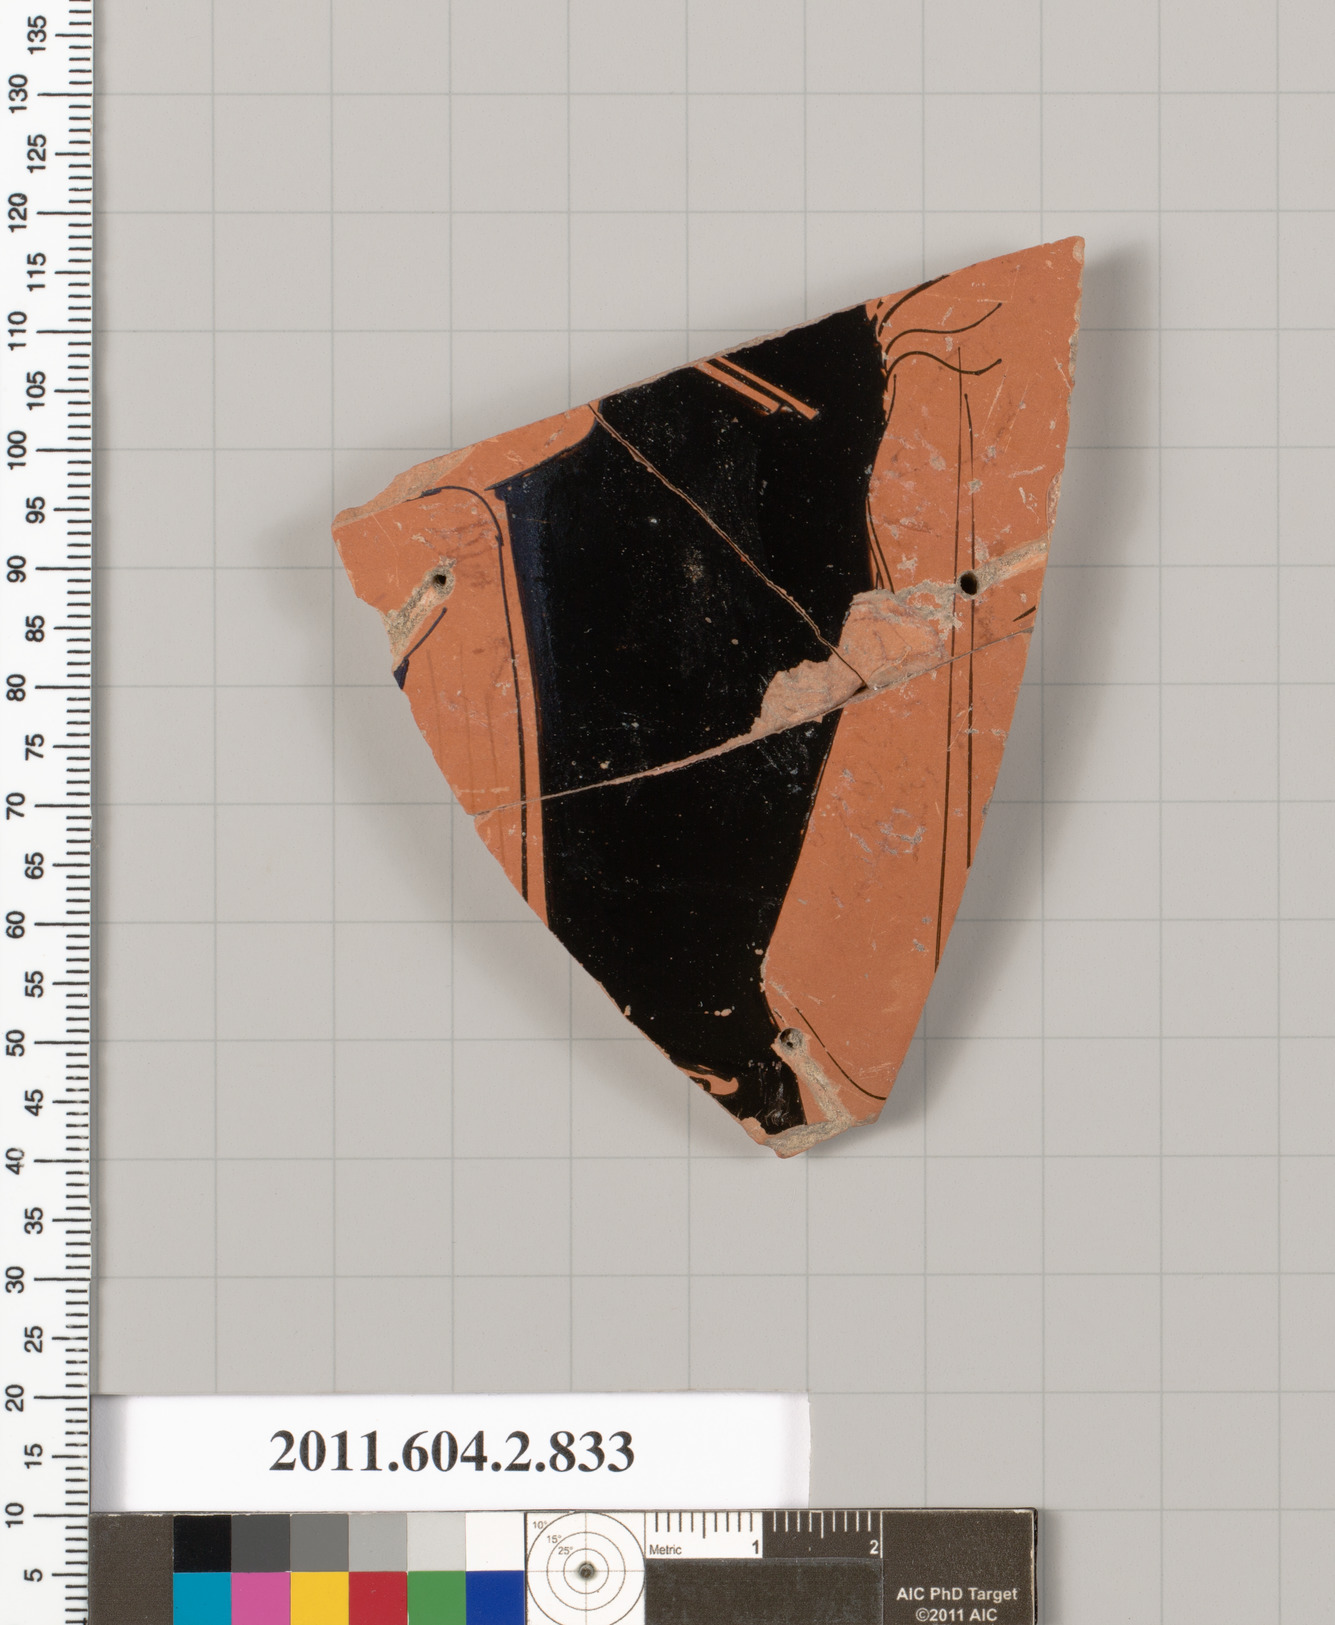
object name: bell krater fragment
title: Terracotta fragment of a bell-krater (bowl for mixing wine and water)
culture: greek, attic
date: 467-435 BCE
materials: terracotta